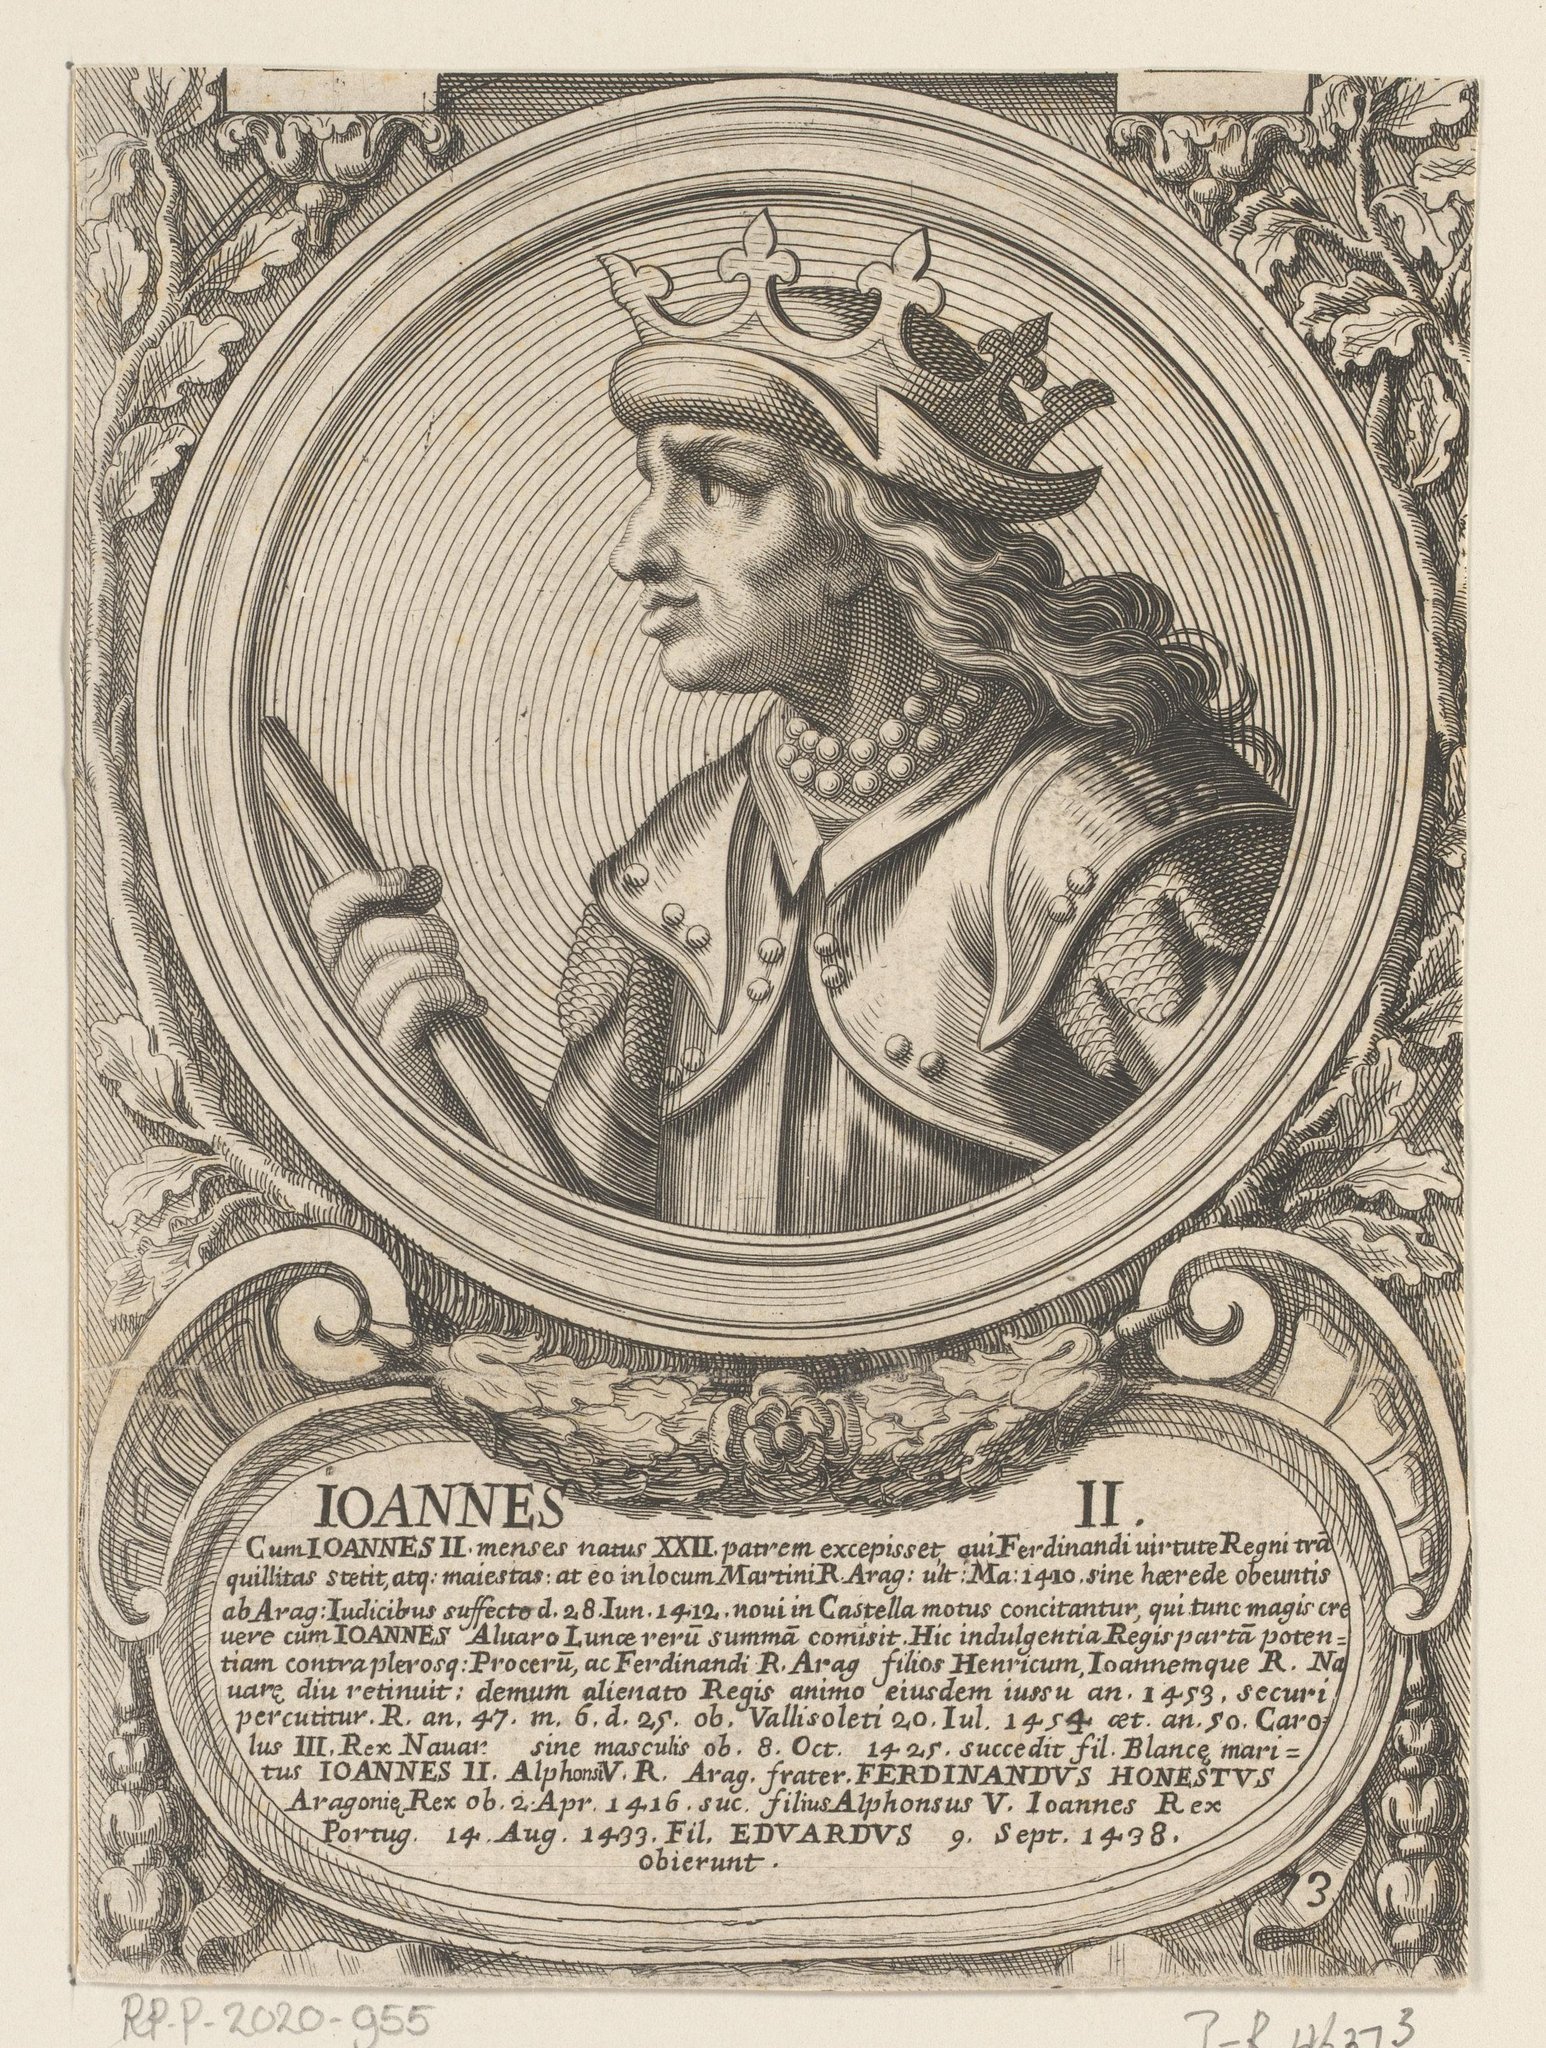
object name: print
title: Portret van Johan II, koning van Castilië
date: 1685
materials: paper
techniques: engraving, etching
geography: rome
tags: historical persons, ruler, sovereign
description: Portret afkomstig van een grote prent, getiteld 'Series Chronologica et Imagines Regu Hispaniae ab Ataulpho ad Carolum II', bestaande uit tien bladen die samengevoegd konden worden, uitgegeven door Giovanni Giacomo de' Rossi in 1685.